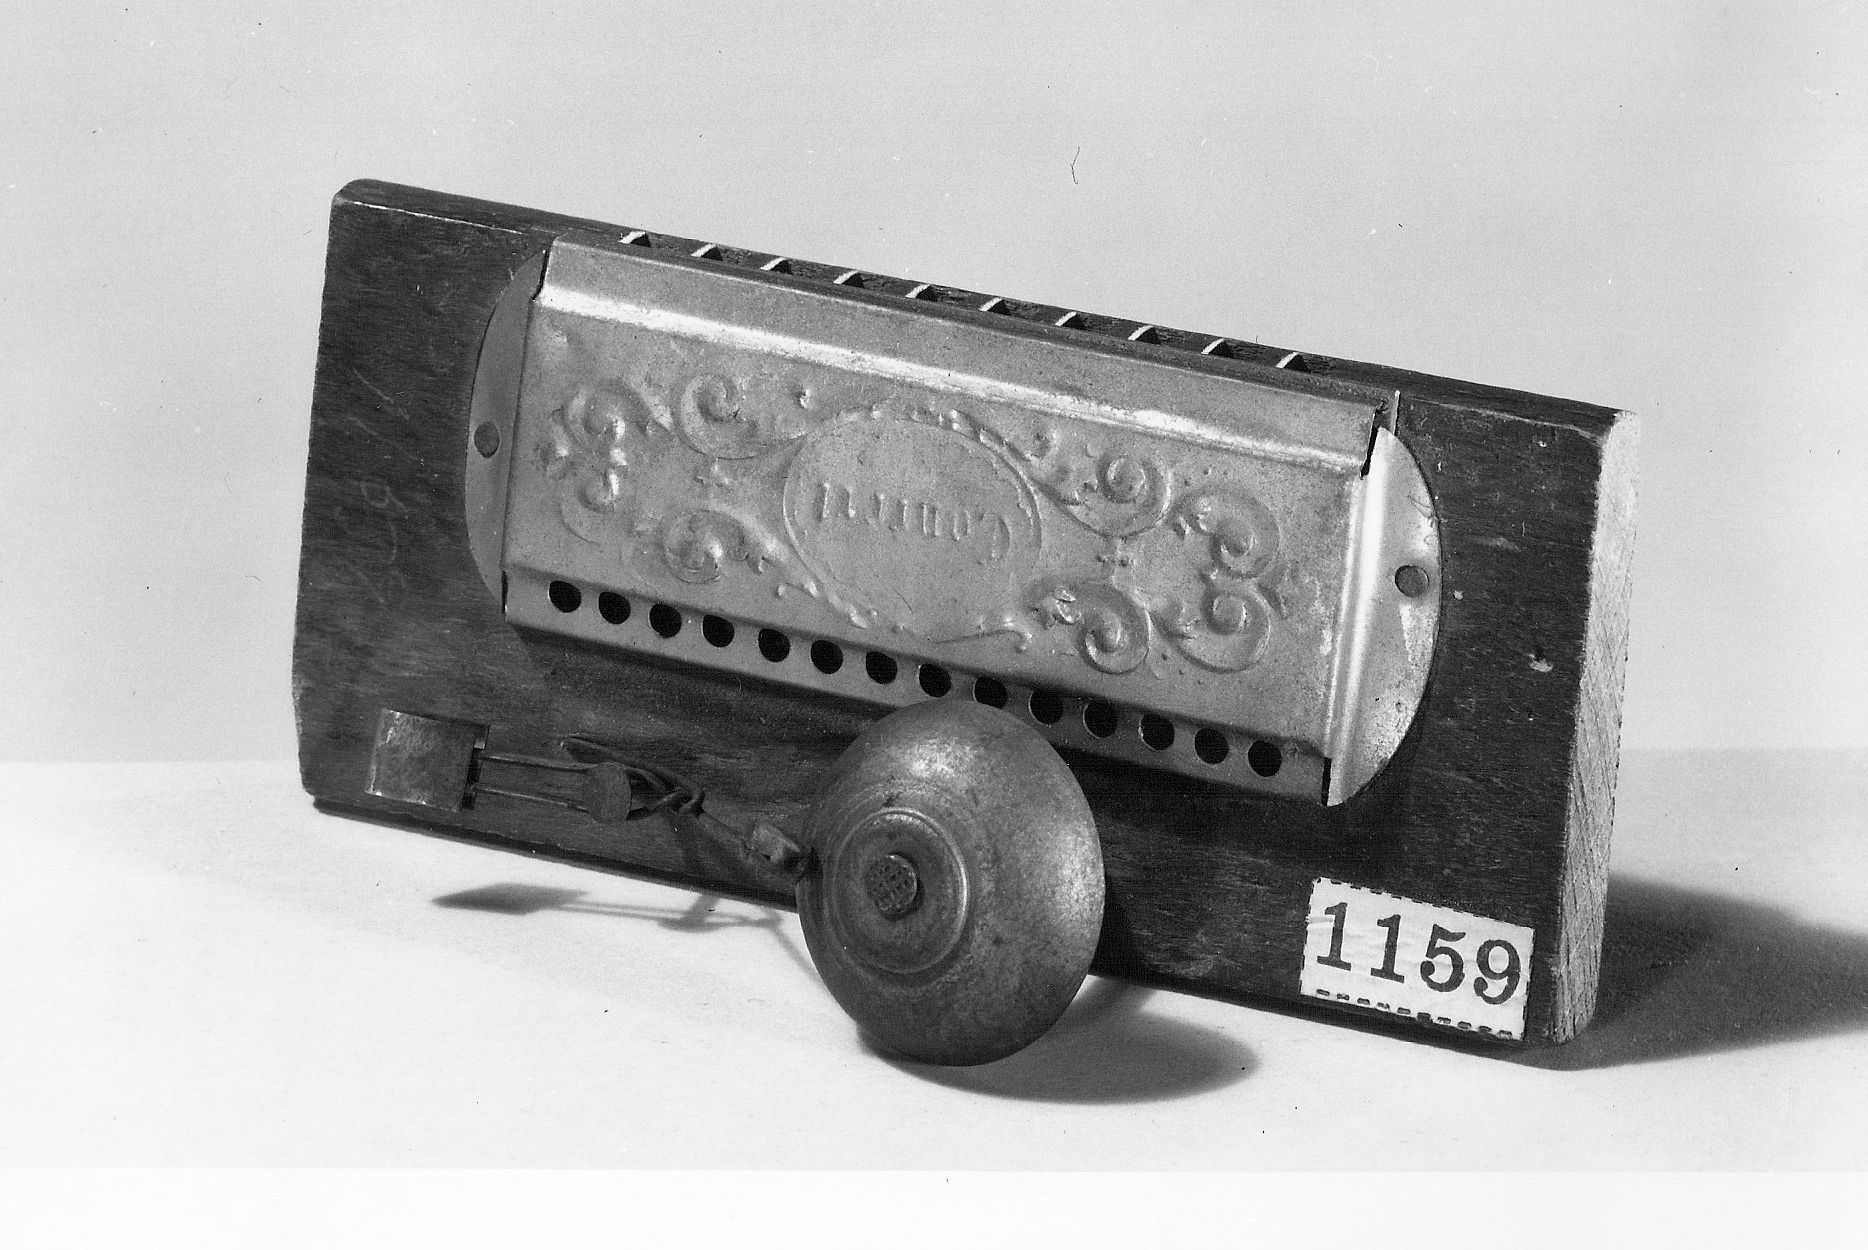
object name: harmonica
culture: german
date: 1901-1933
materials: metal, wood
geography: germany